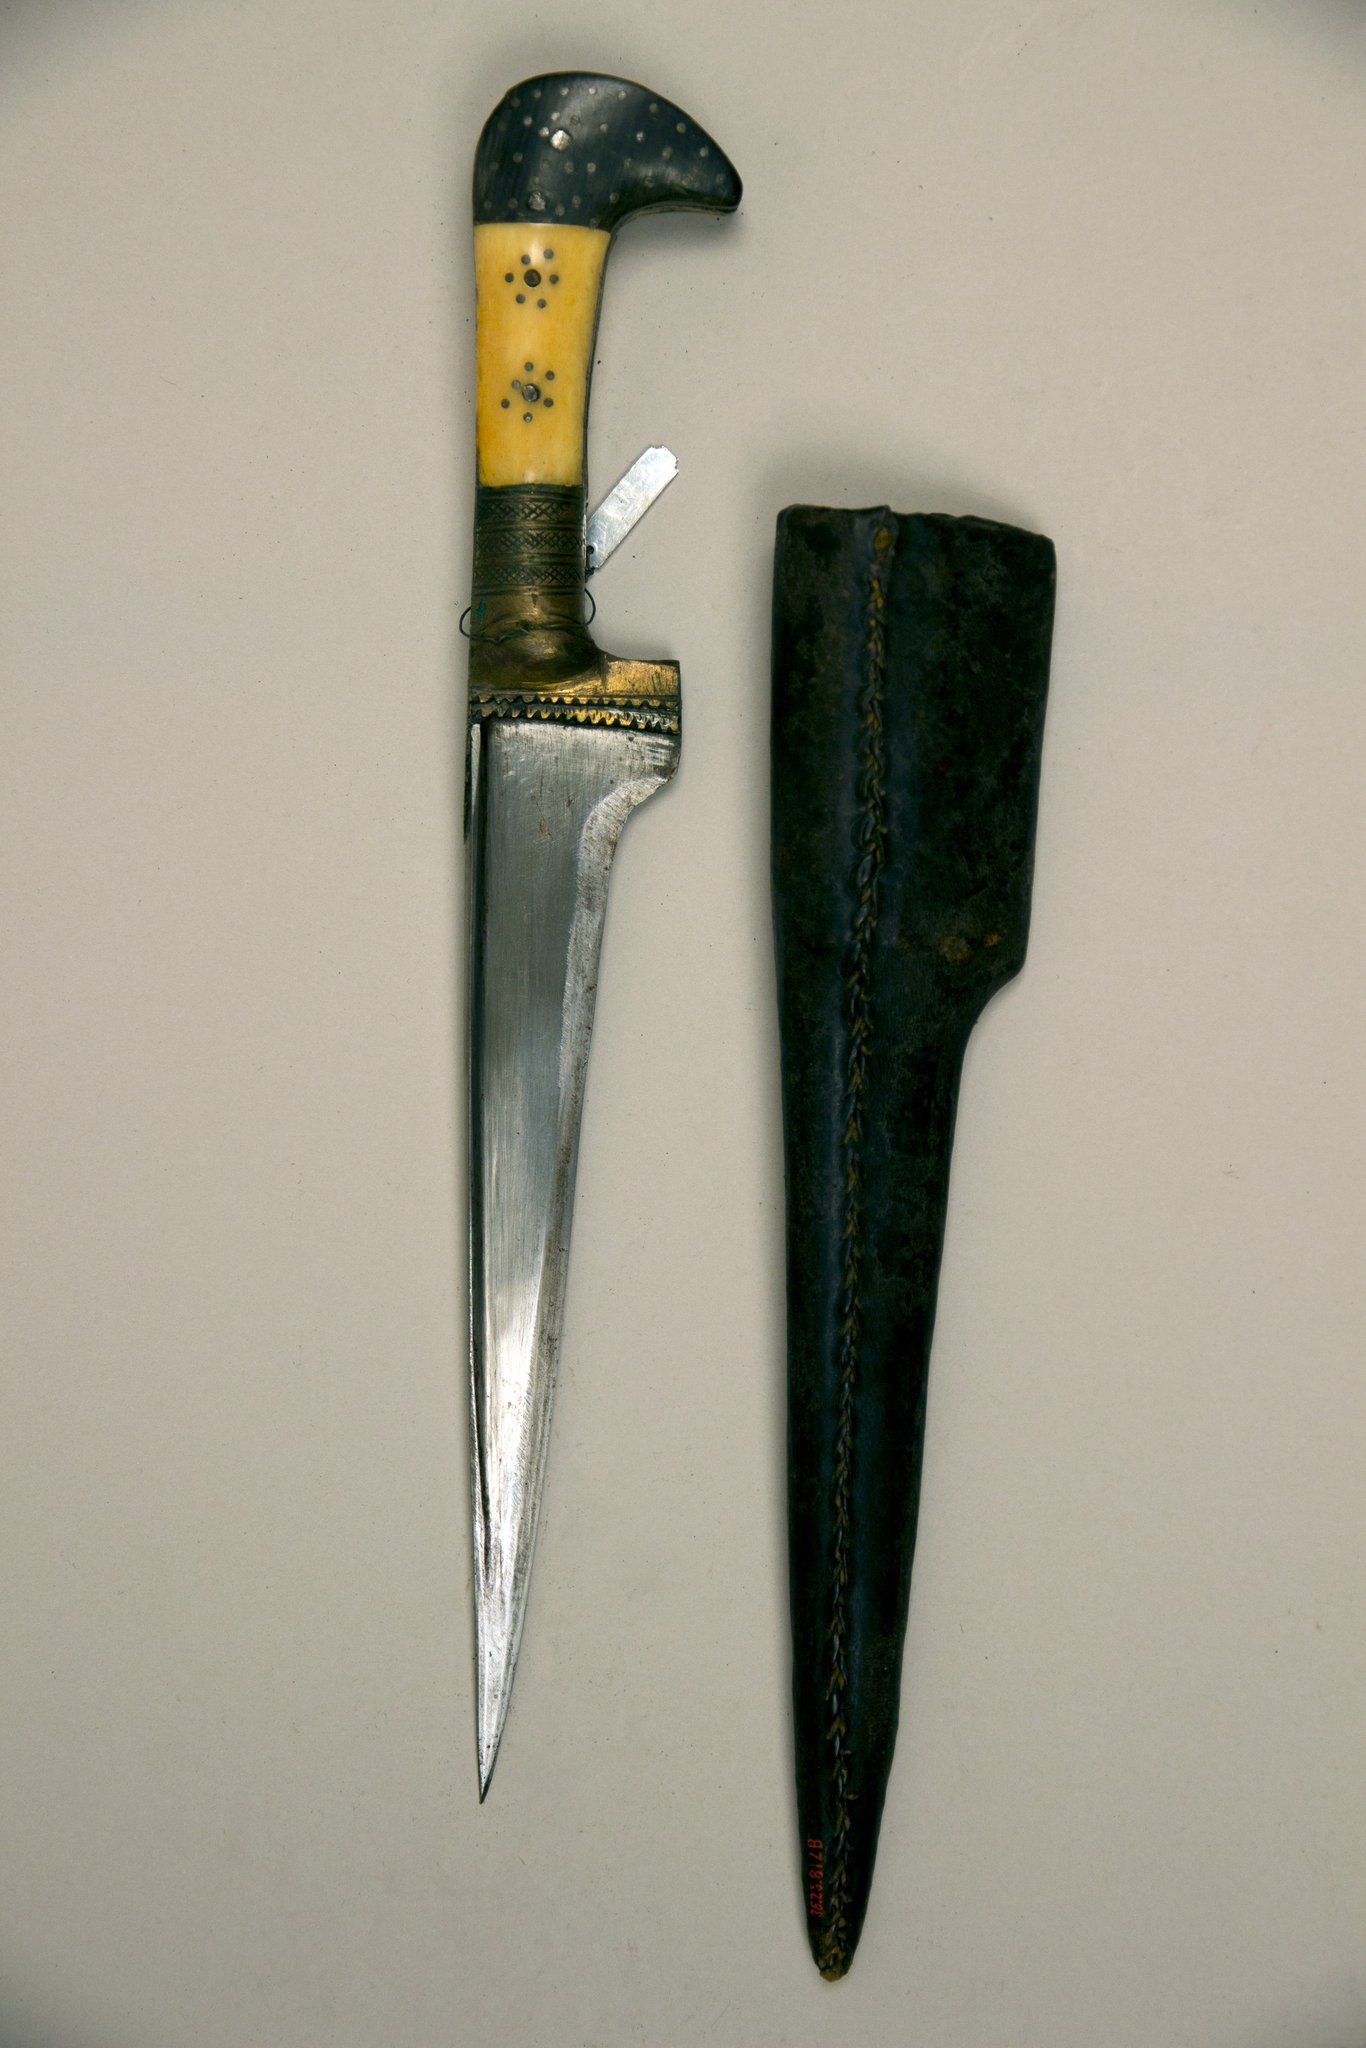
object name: dagger choora with sheath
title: Dagger (Choora) with Sheath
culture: indian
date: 1801-1900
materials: brass, horn, leather, steel, wood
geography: india